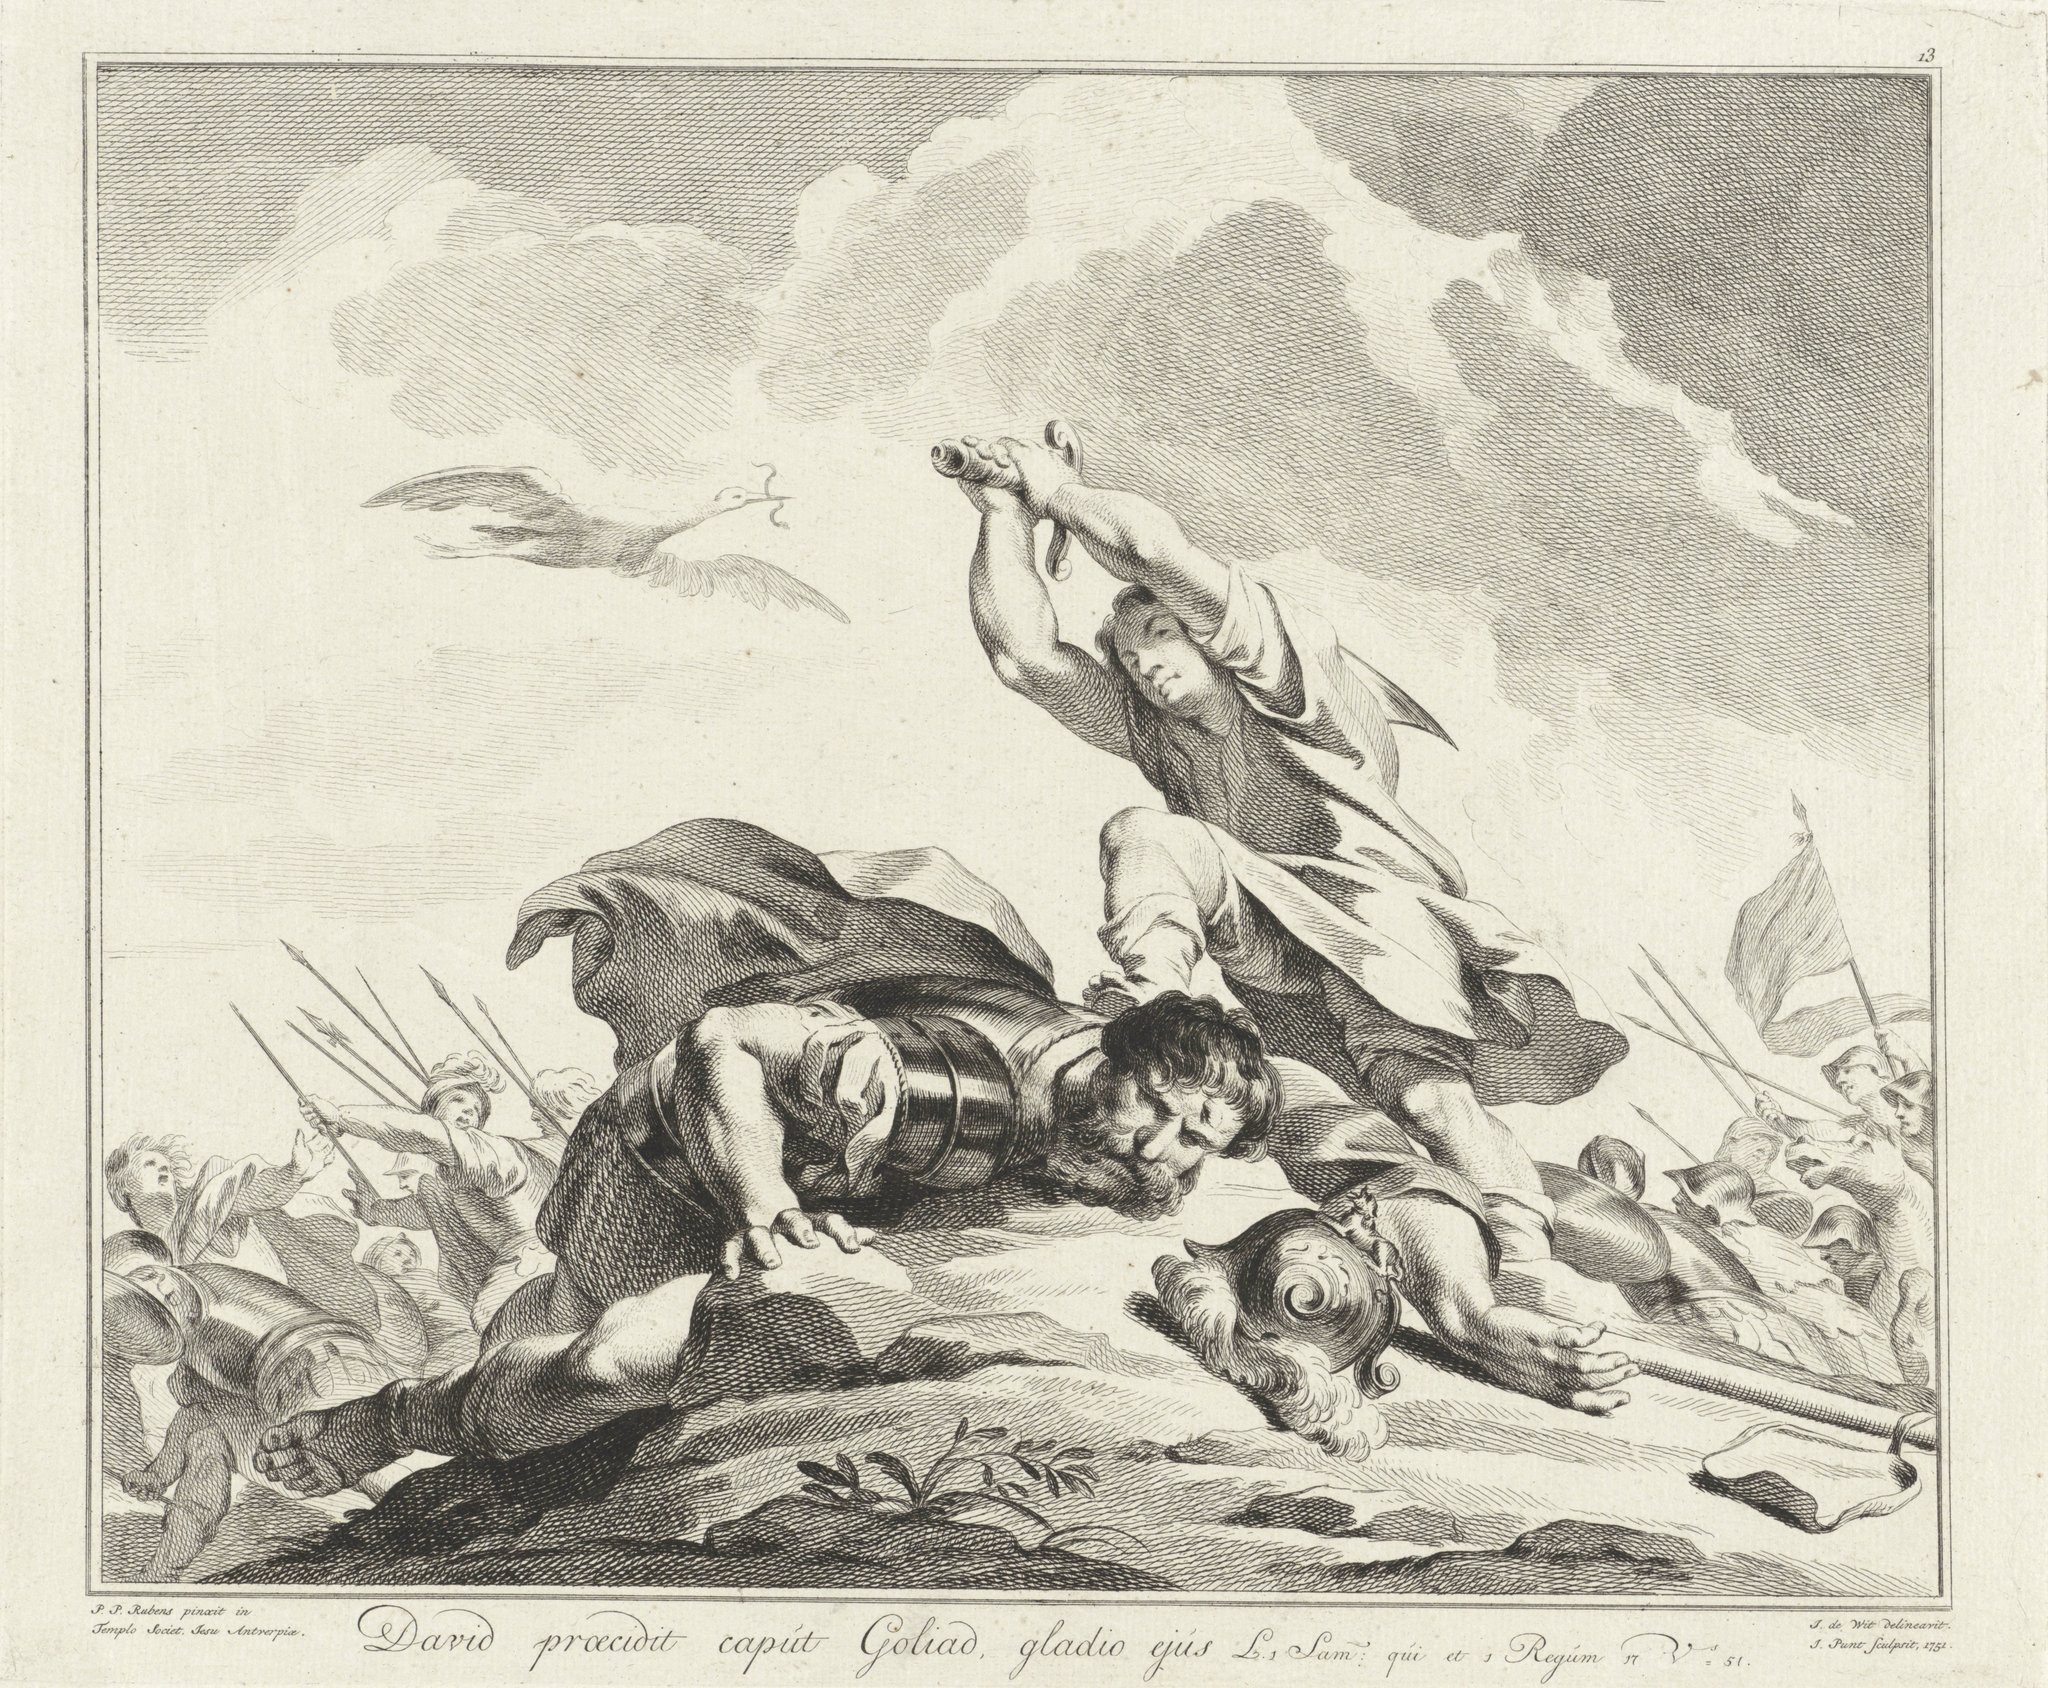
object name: print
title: David onthoofdt Goliat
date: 1752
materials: paper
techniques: engraving, etching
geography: amsterdam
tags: david beheads goliath with a sword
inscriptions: date: ‘1752’, collector's mark: Lugt 240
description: Goliat ligt op de grond en David staat op het punt zijn hoofd af te houwen. Onder de rechthoekige voorstelling een vers in het Latijn uit 1 Sam. 17:51.